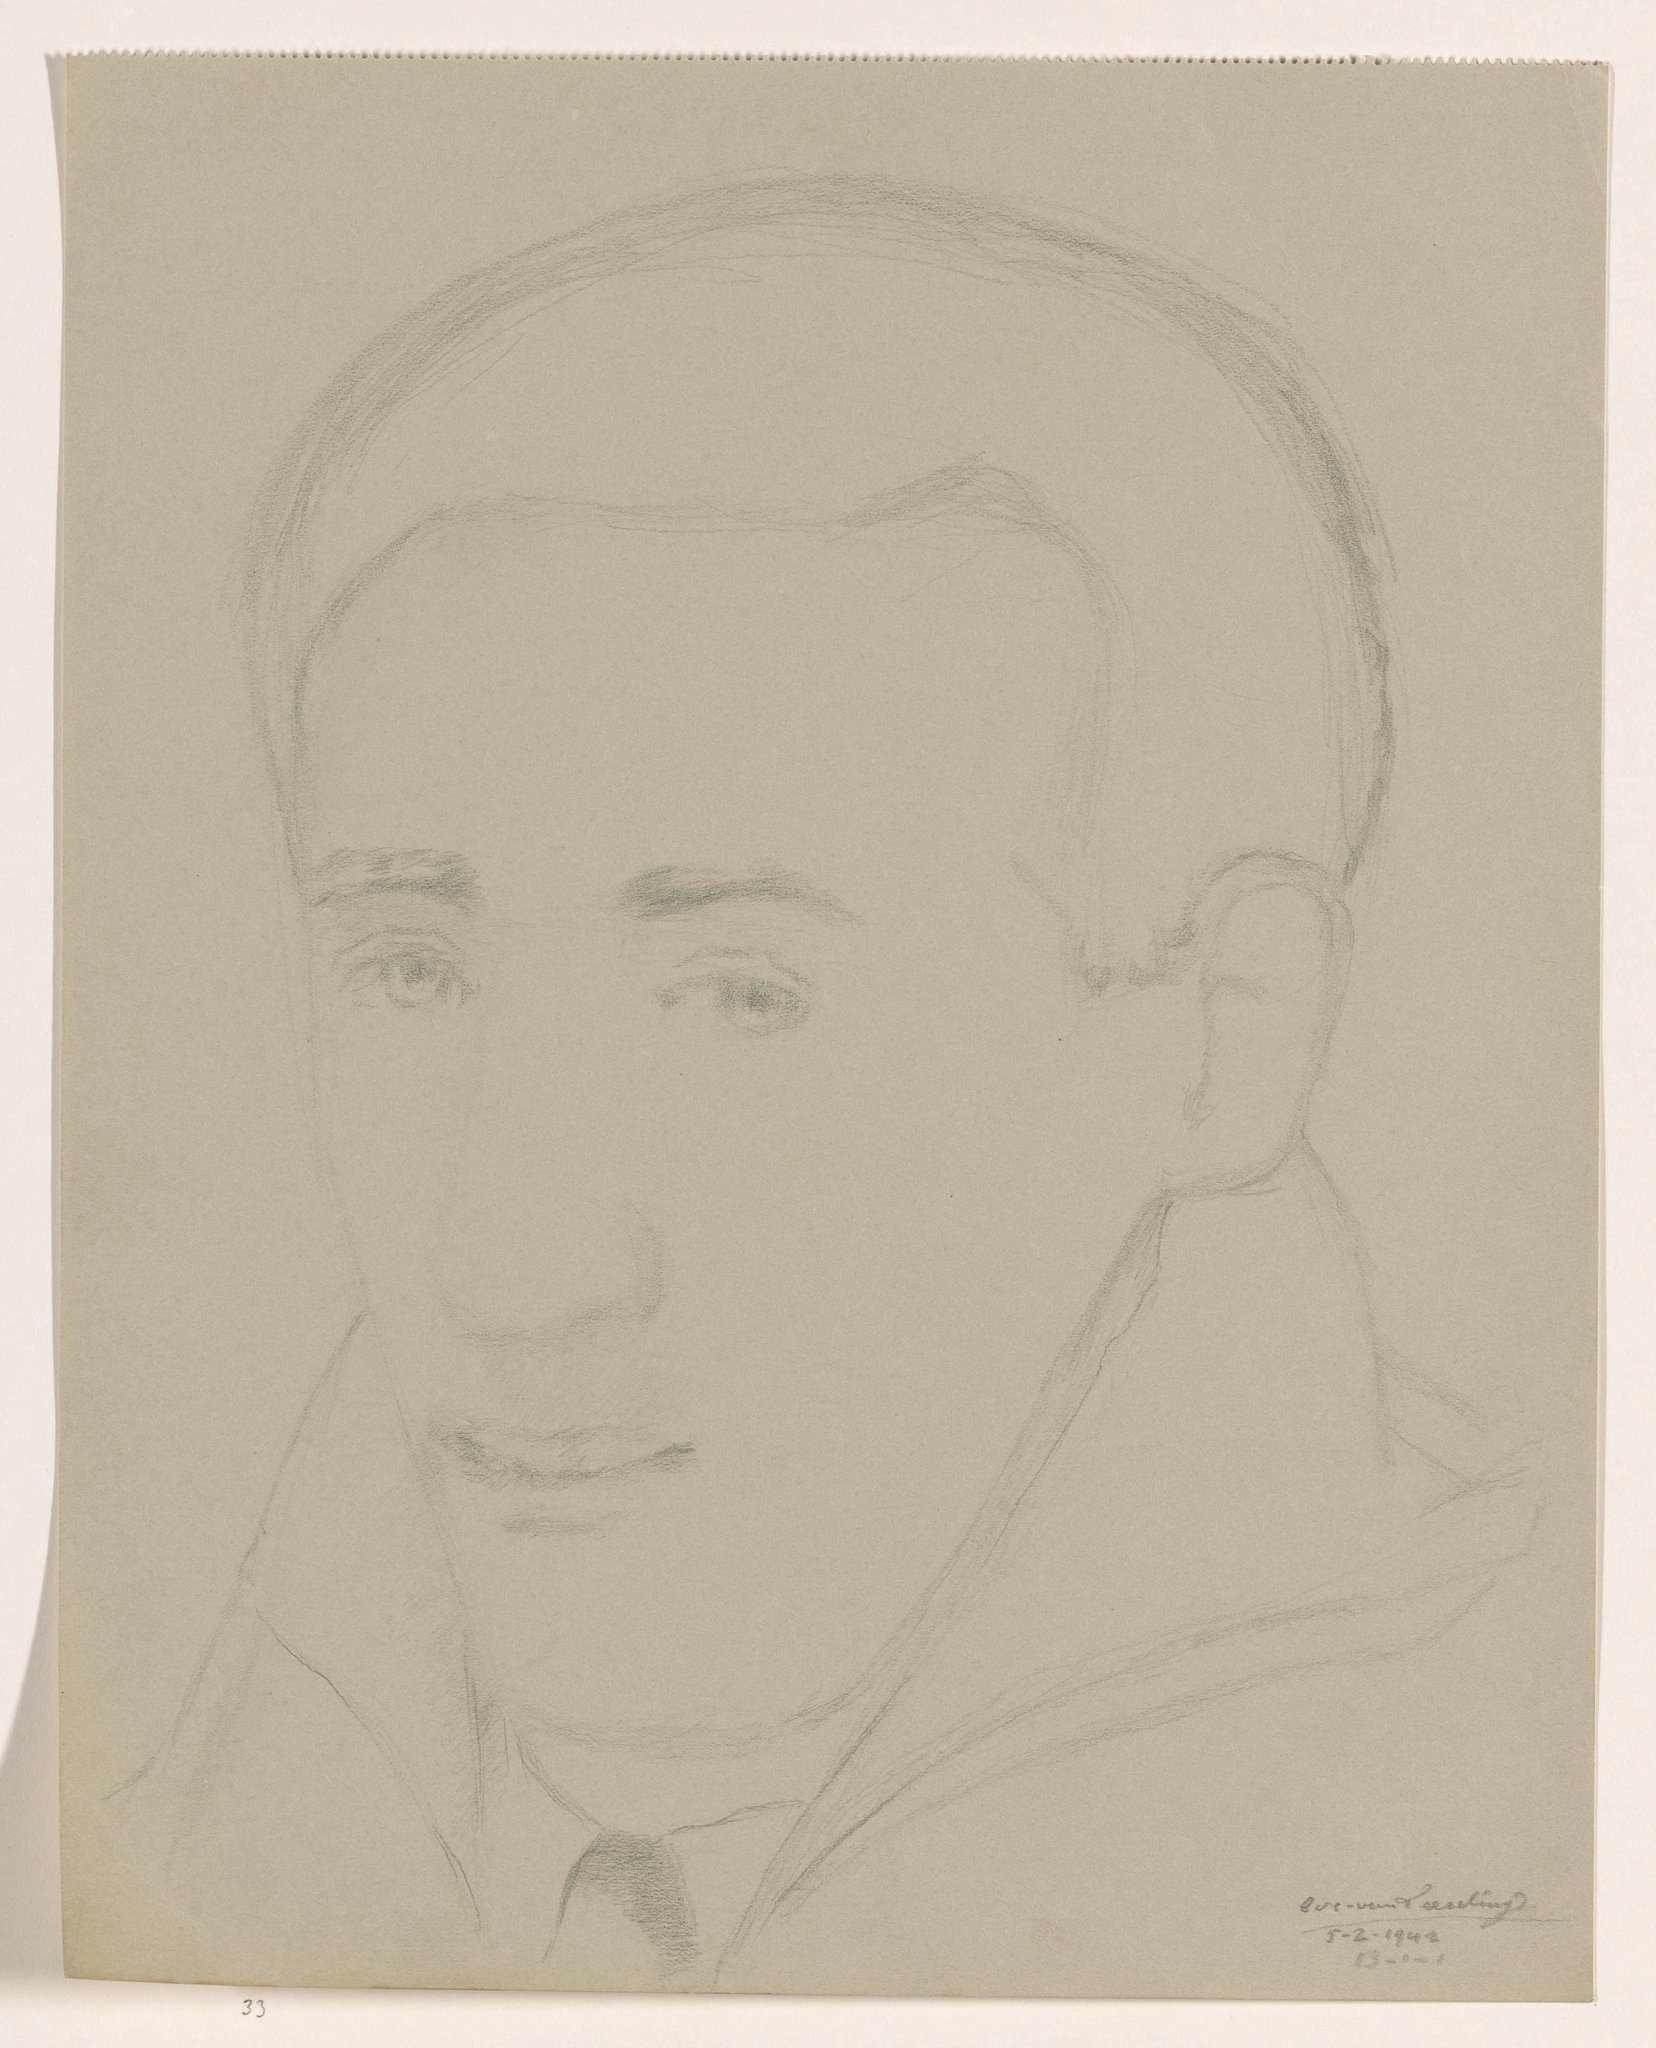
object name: drawing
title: Zelfportret: B-1-1, 5 februari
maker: cor van teeseling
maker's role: draughtsman, sculptor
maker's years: 1915-1942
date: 1942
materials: paper, pencil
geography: weteringschans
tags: amsterdam, draughtsman, sculptor, cor van teeseling, historical persons, prisoner in cell or locked place, portrait, self-portrait of draughtsman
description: Zelfportret van Cor van Teeseling: B-1-1, 5 februari. Getekend zelfportret van Cor van Teeseling driekwart met zijn hoofd naar links gewend.